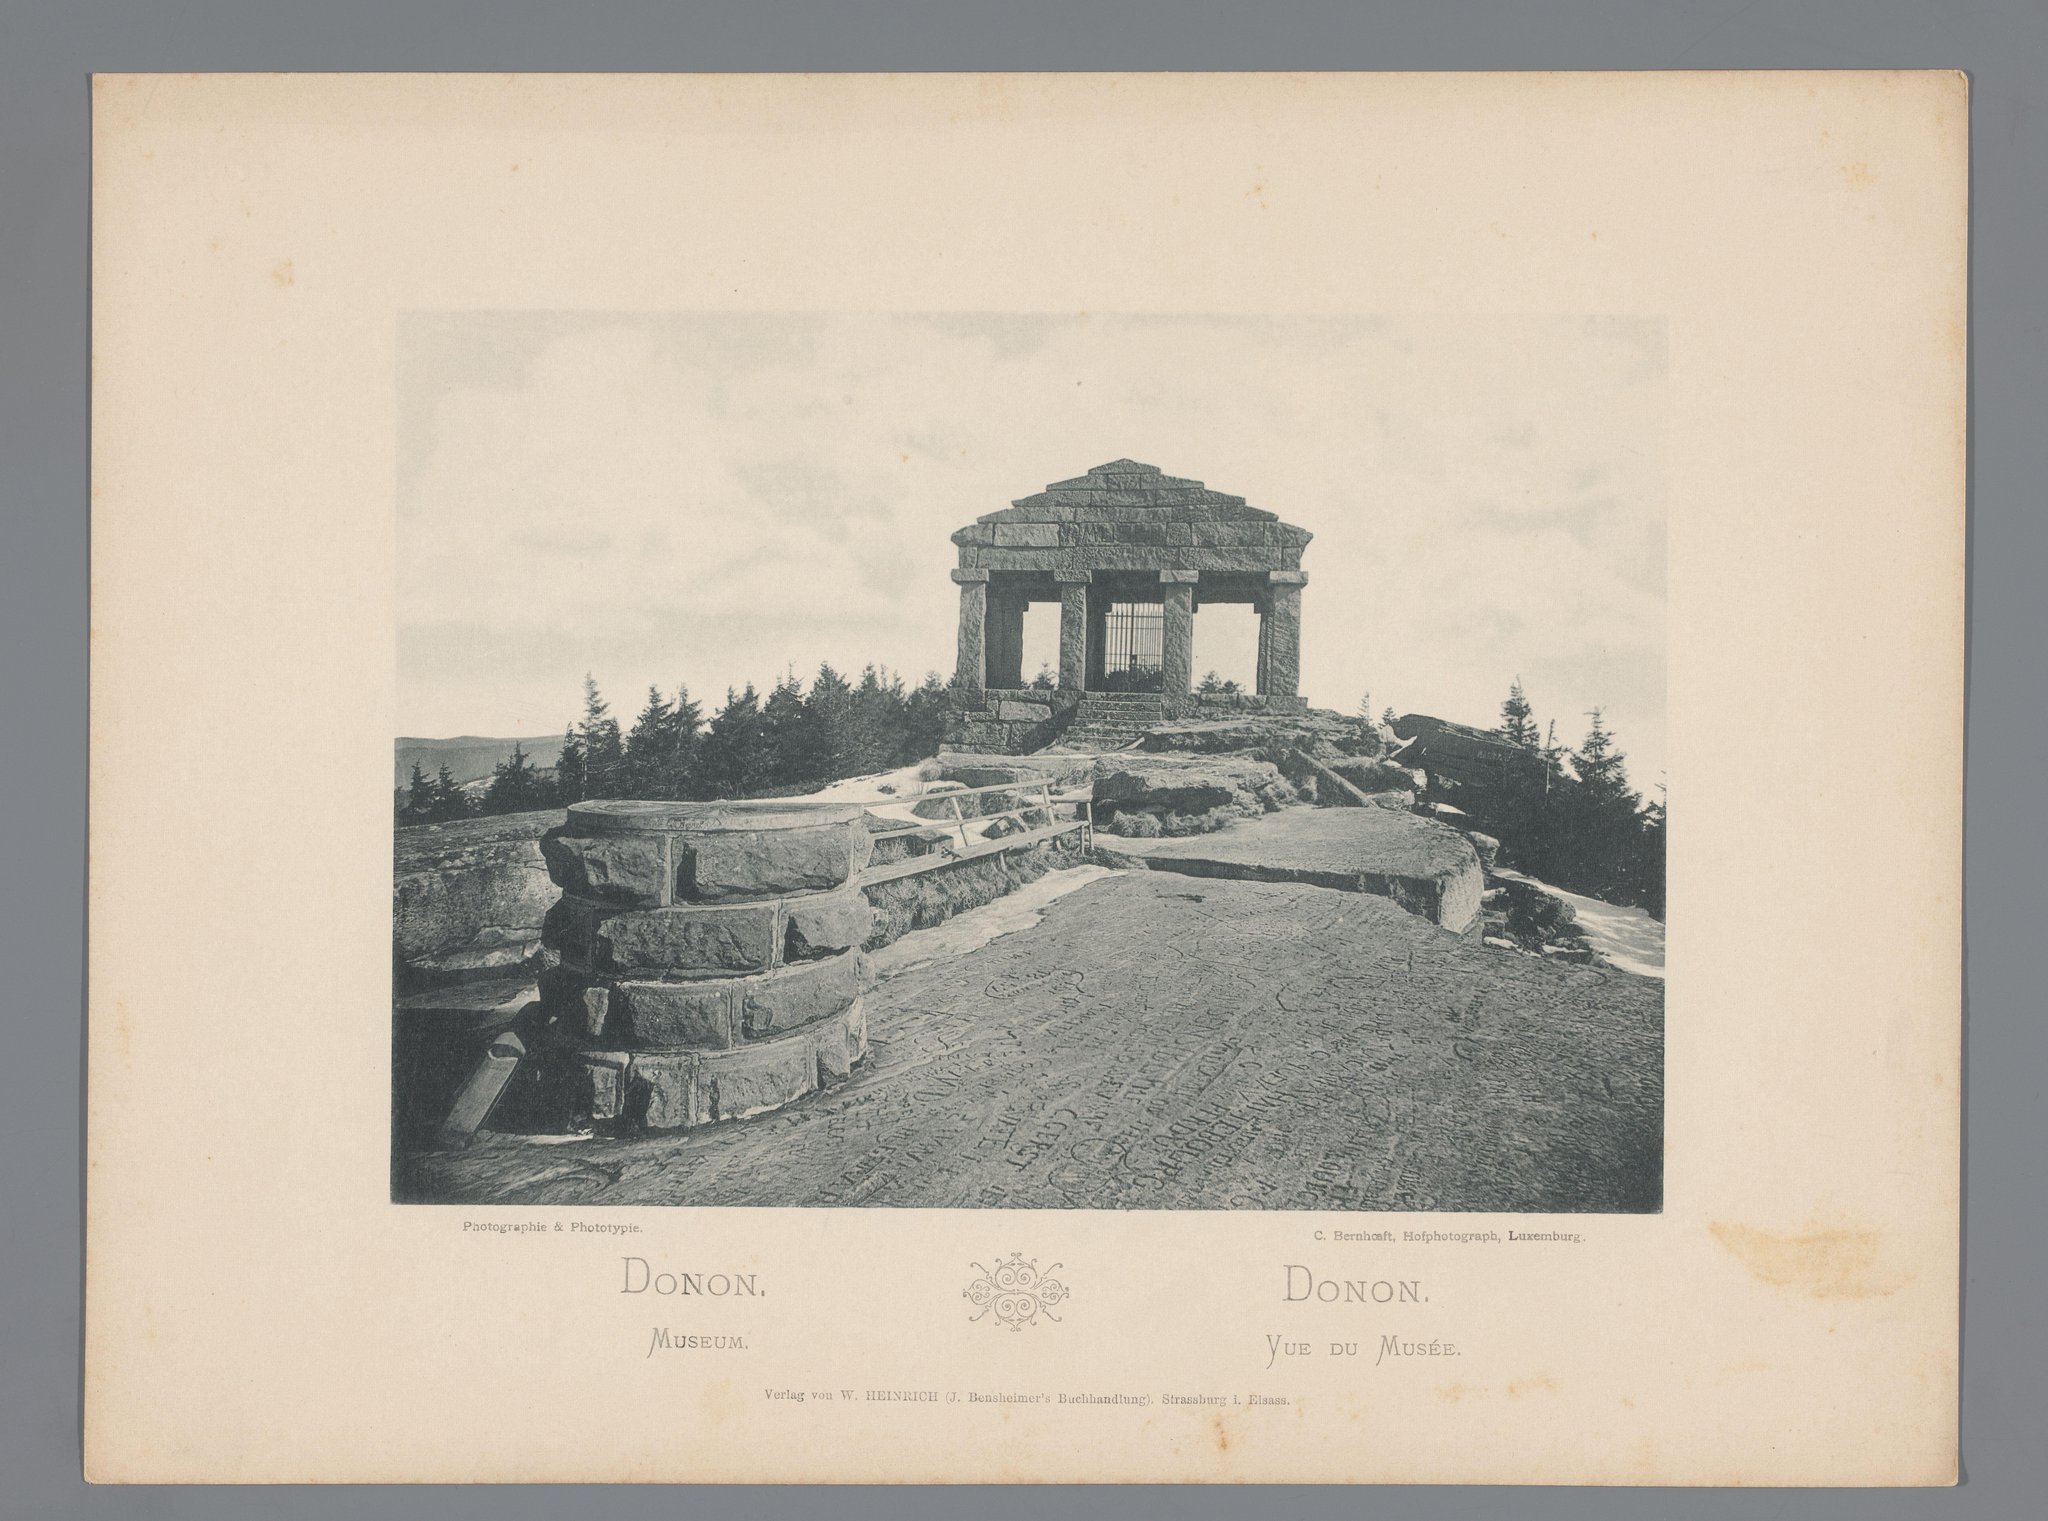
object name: page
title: Donon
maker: charles bernhoeft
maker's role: publisher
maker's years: 1859-1933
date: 1889-1894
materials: paper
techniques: photograph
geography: luxembourg city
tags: mountain-top, peak, temple, shrine ~ non-christian religions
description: Deze prent maakt deel uit van een omslag met 100 prenten.